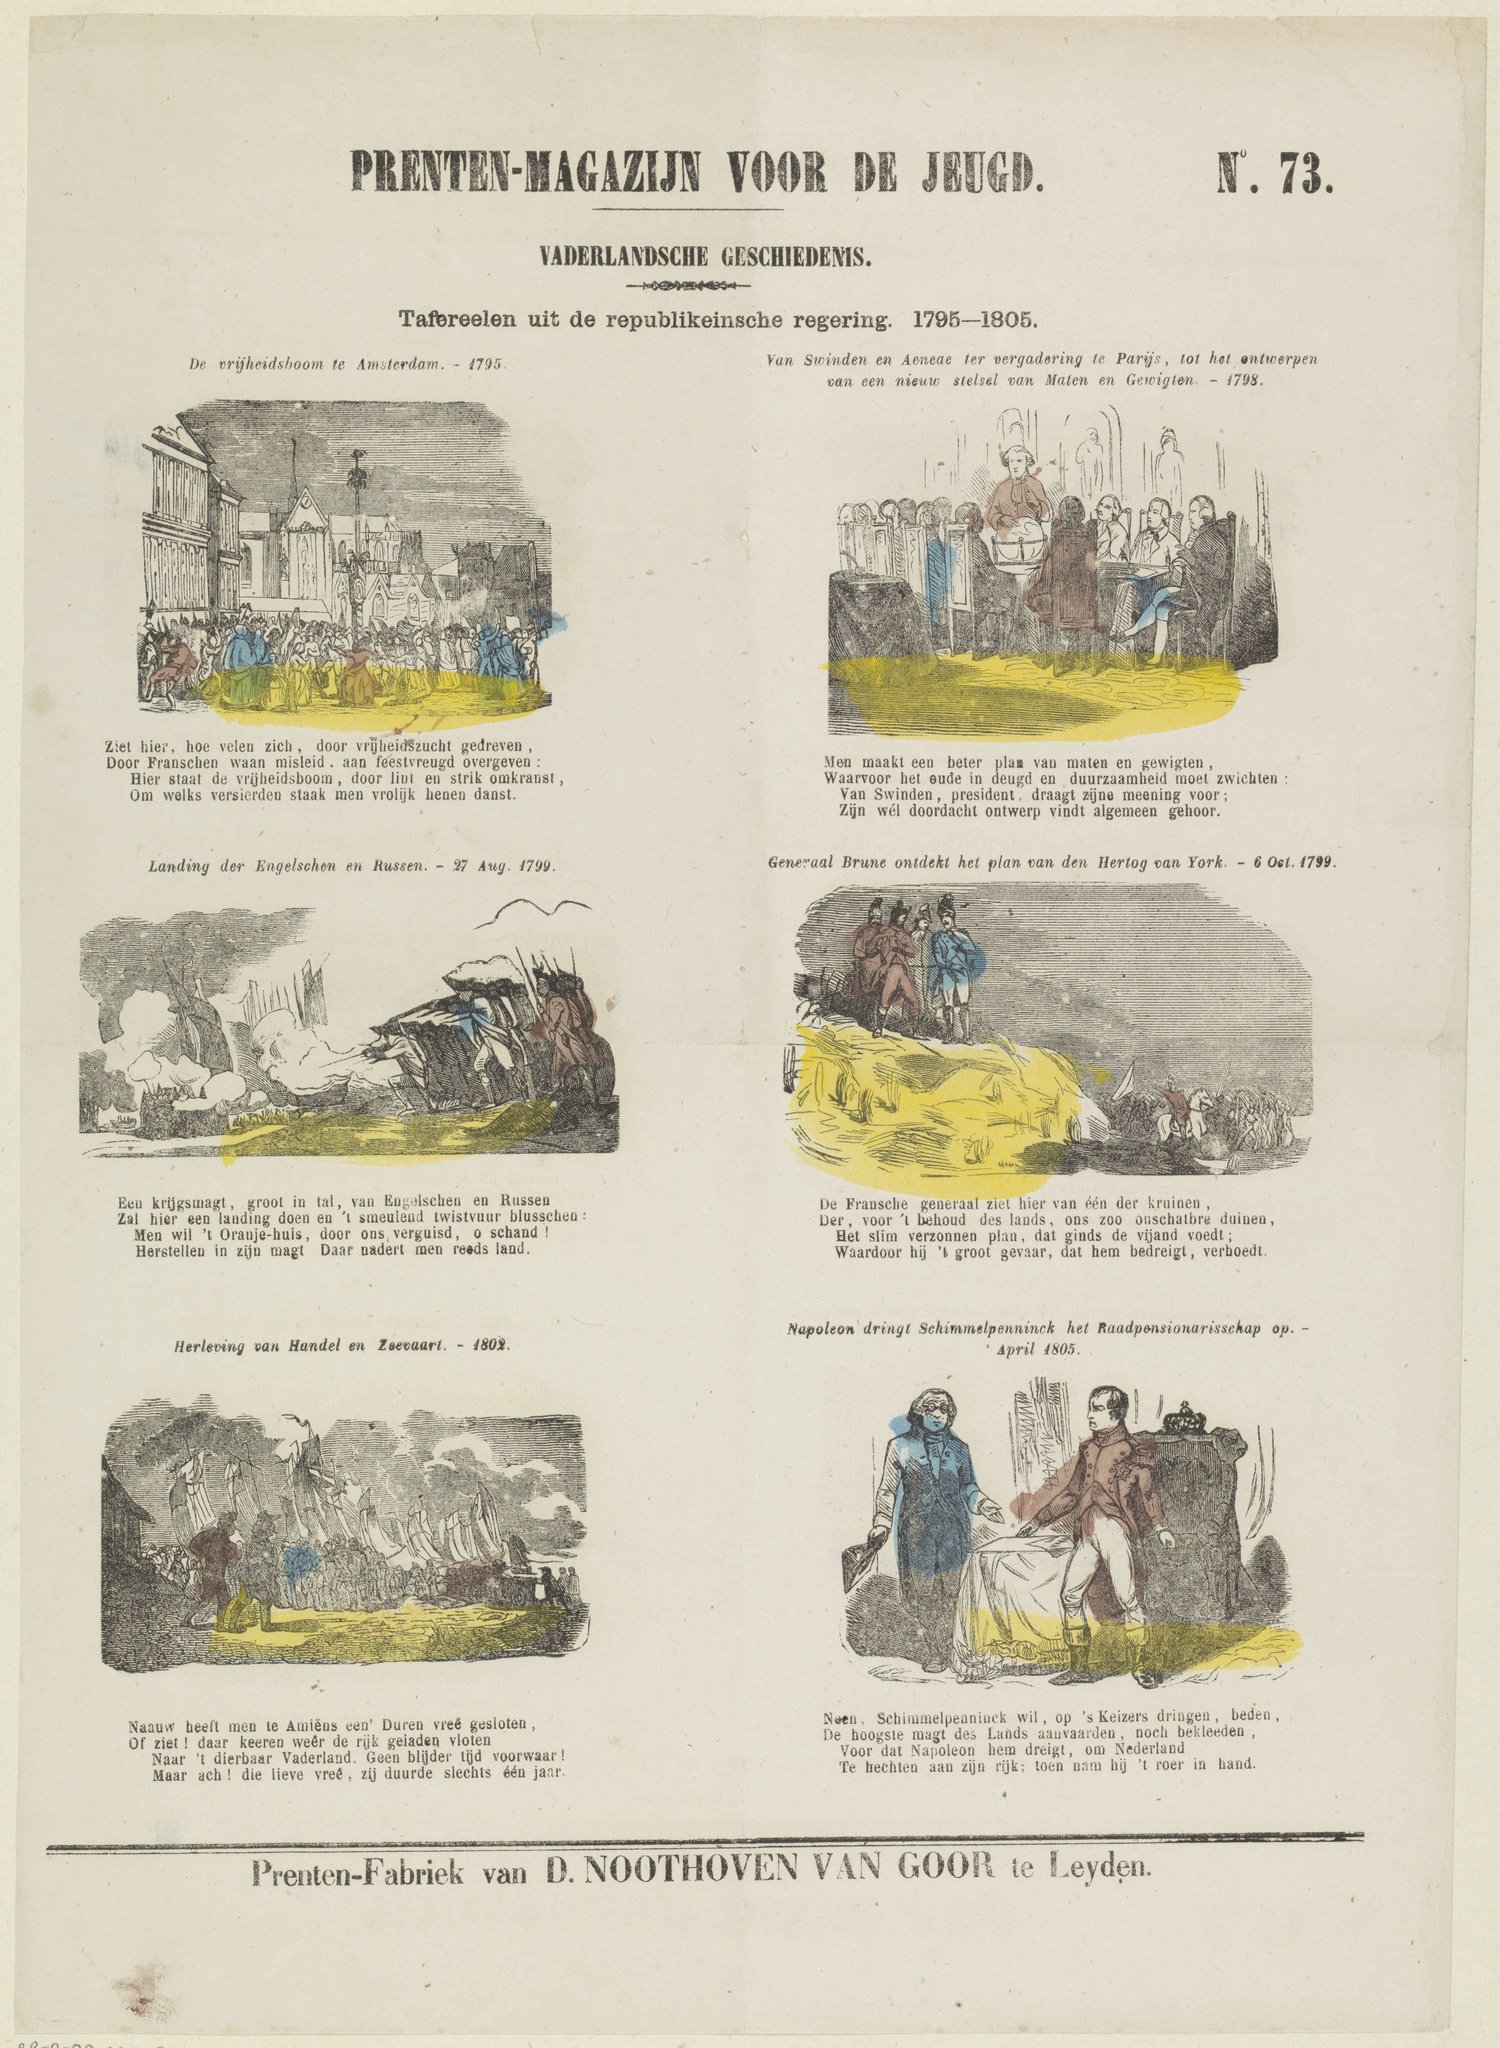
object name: print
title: Prenten-magazijn voor de jeugd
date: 1850-1881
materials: paper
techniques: colour, letterpress printing, engraving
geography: leiden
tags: rutger jan schimmelpenninck (1761-1825), hendrik aeneae, london, frederik (hertog van york en albany), napoleon i (emperor of the french), the hague, amsterdam, physicist, jean henri van swinden, history, paris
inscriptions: collector's mark: Lugt 2228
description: Blad met 6 voorstellingen van gebeurtenissen ten tijde van de Bataafse Republiek (1794-1801). Boven elke voorstelling een titel en onder elke voorstelling een vierregelig vers. Genummerd rechtsboven: No. 73.